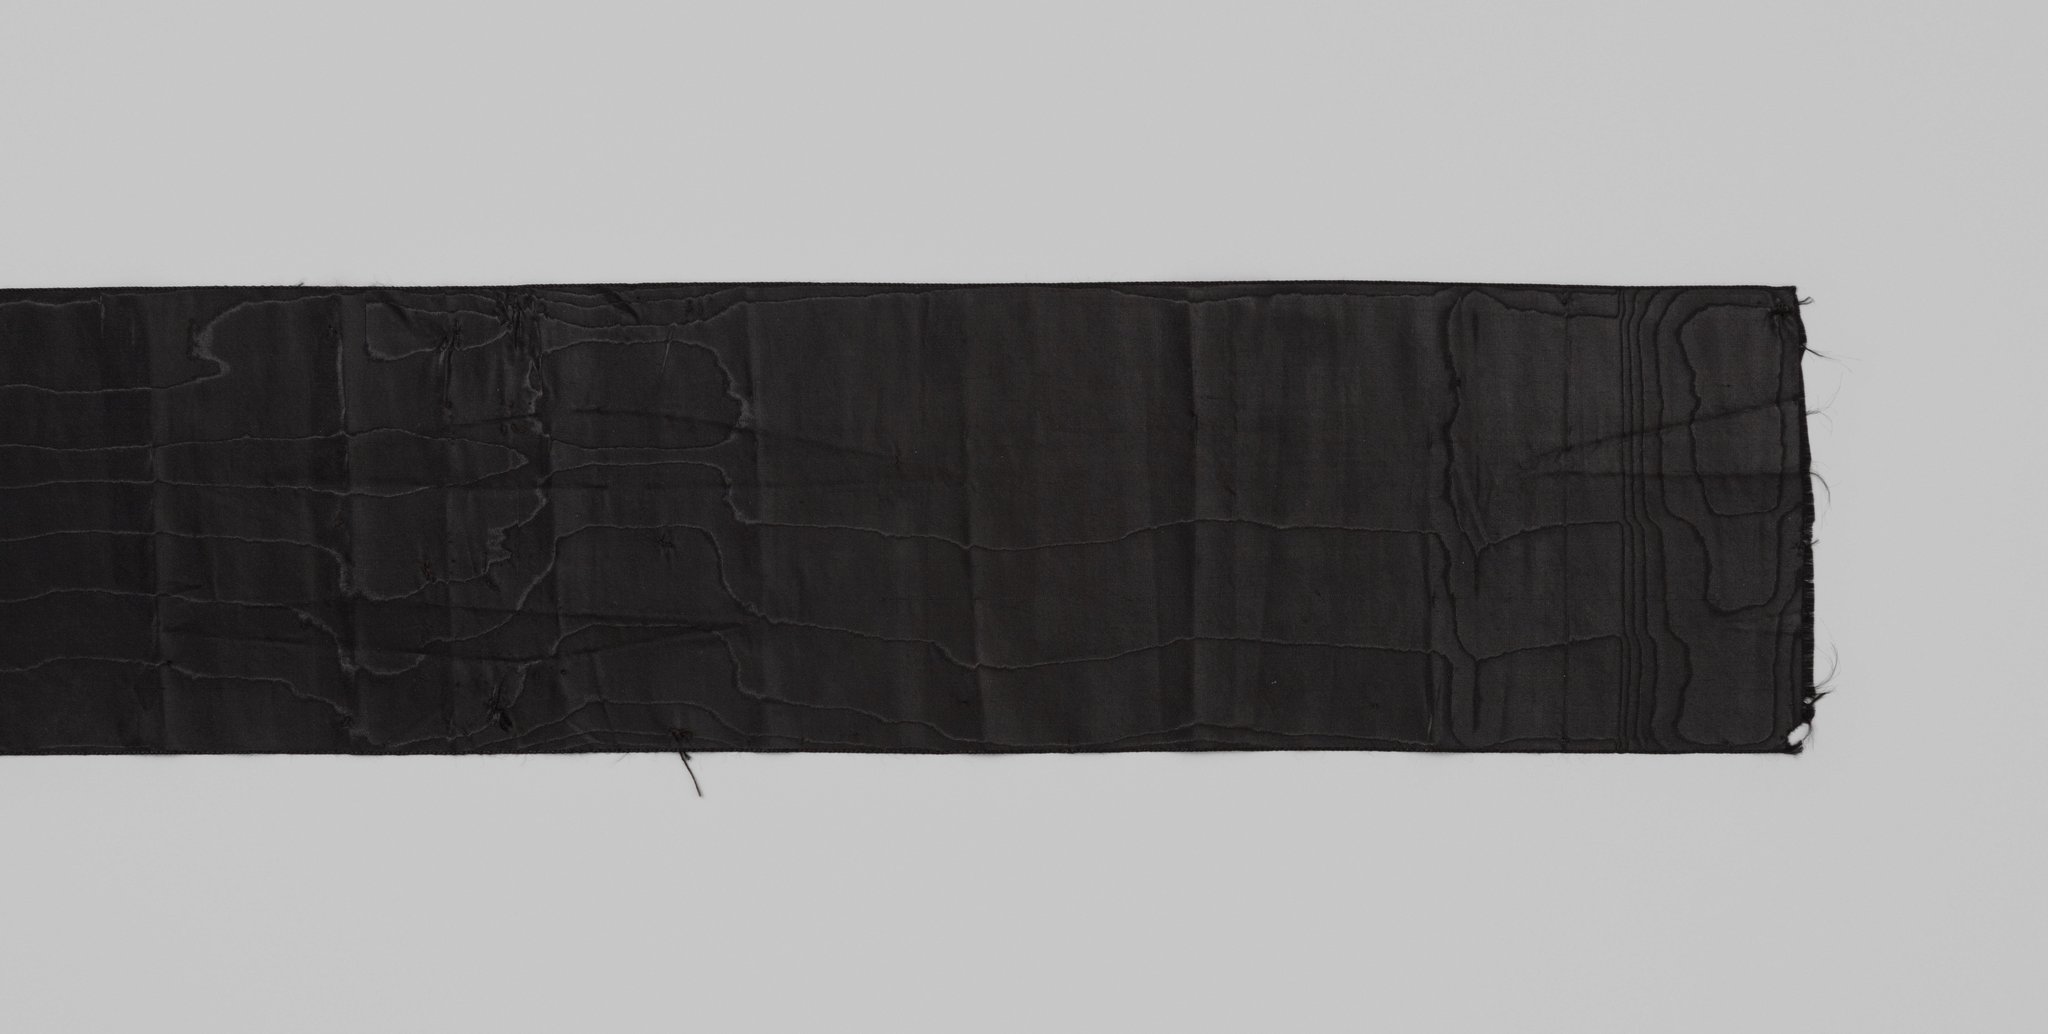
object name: ribbon material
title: Lint van zwarte moiré zijde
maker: Anonymous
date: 1400-1950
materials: silk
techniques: moire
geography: western europe